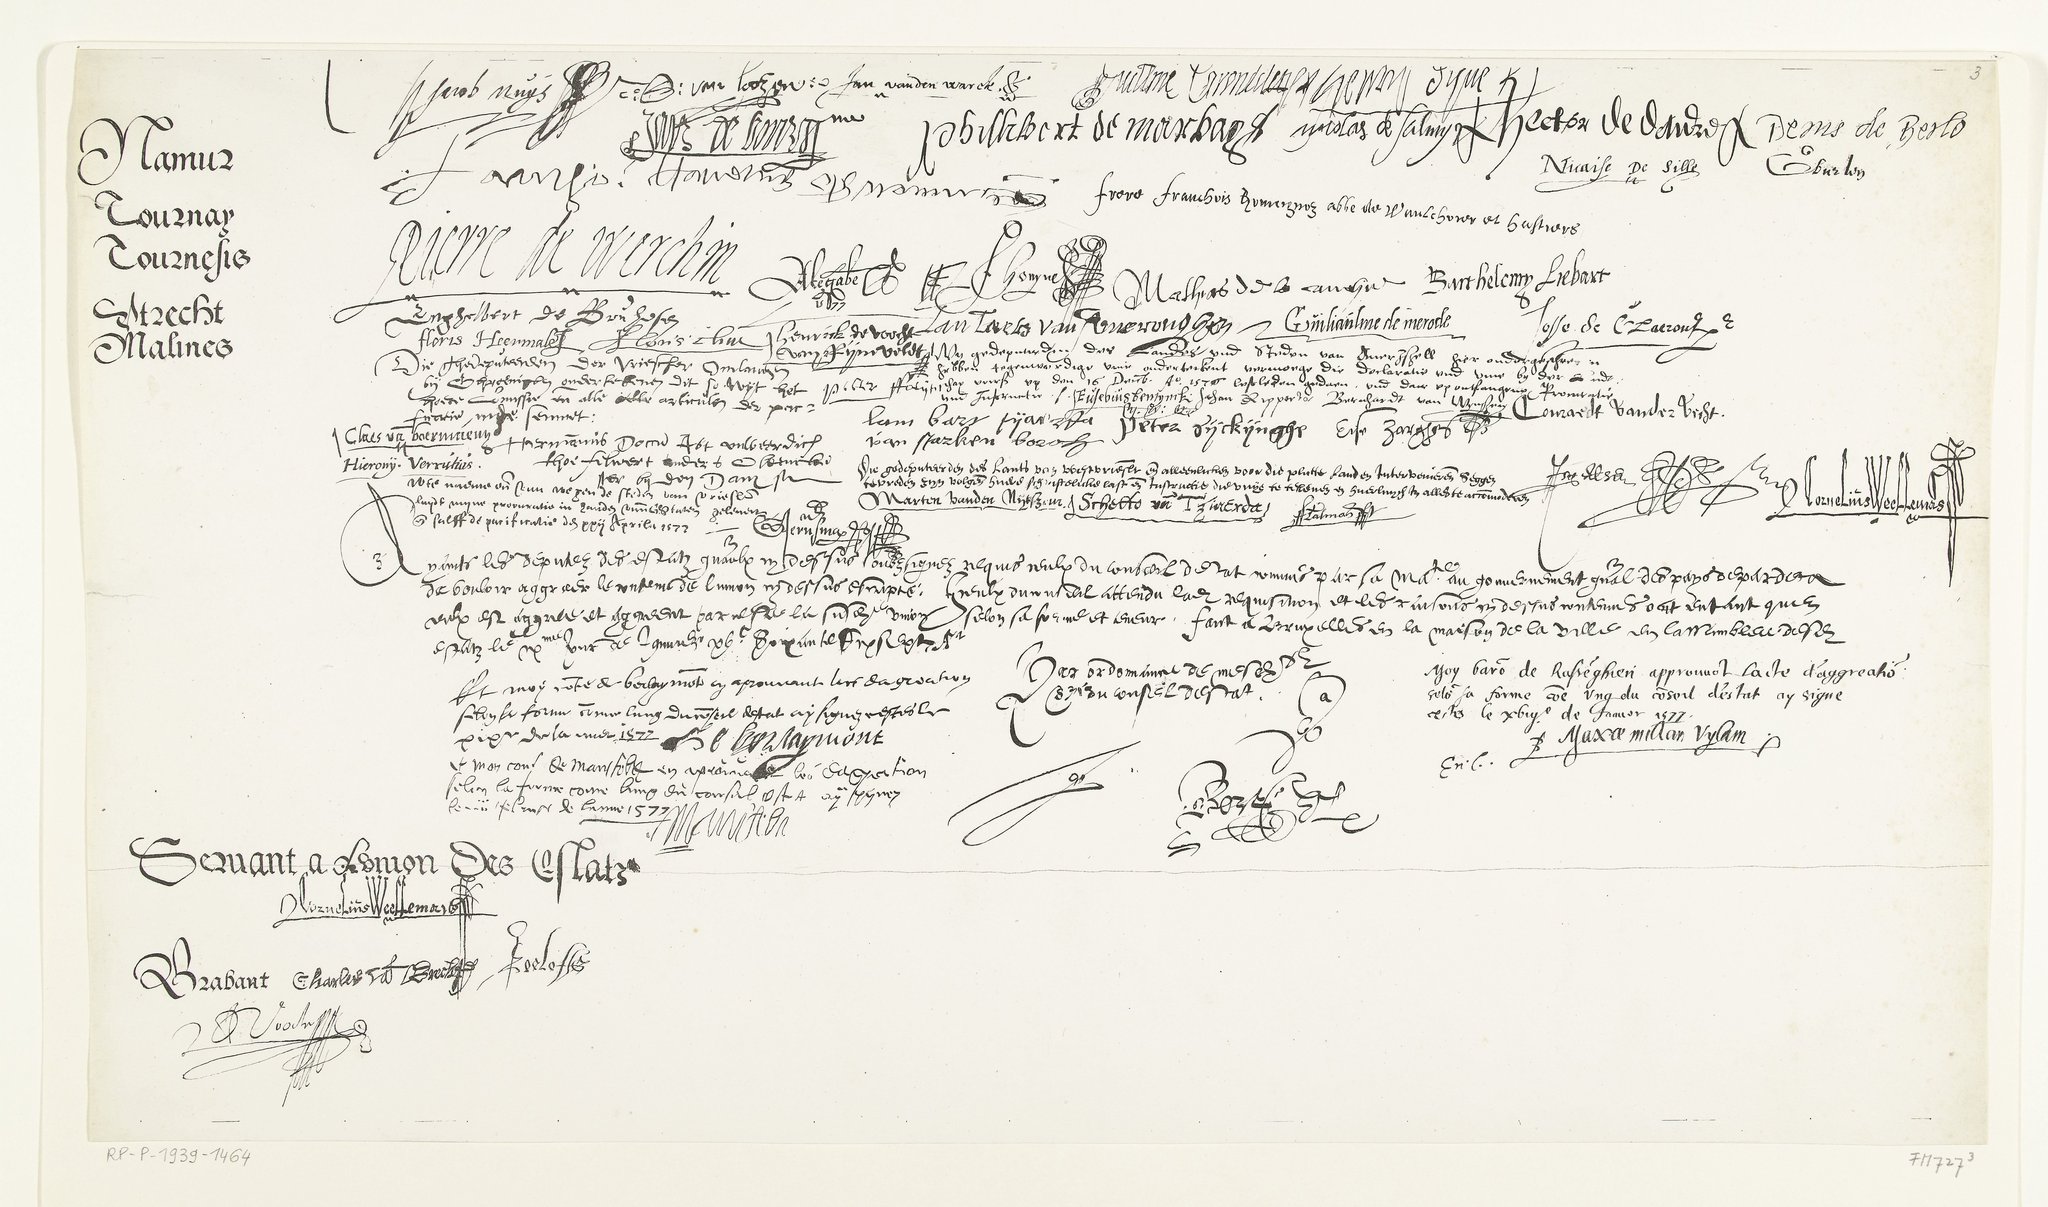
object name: print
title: Facsimile van de Unie van Brussel, 1577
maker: daniël abrahams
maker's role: print maker, printer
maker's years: 1795-1854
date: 1827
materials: paper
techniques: lithograph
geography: the hague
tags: unie van brussel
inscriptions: collector's mark: Lugt 2760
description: Derde blad van de facsimile van het geschrift van de Unie van Brussel met handtekeningen, 9 januari 1577.